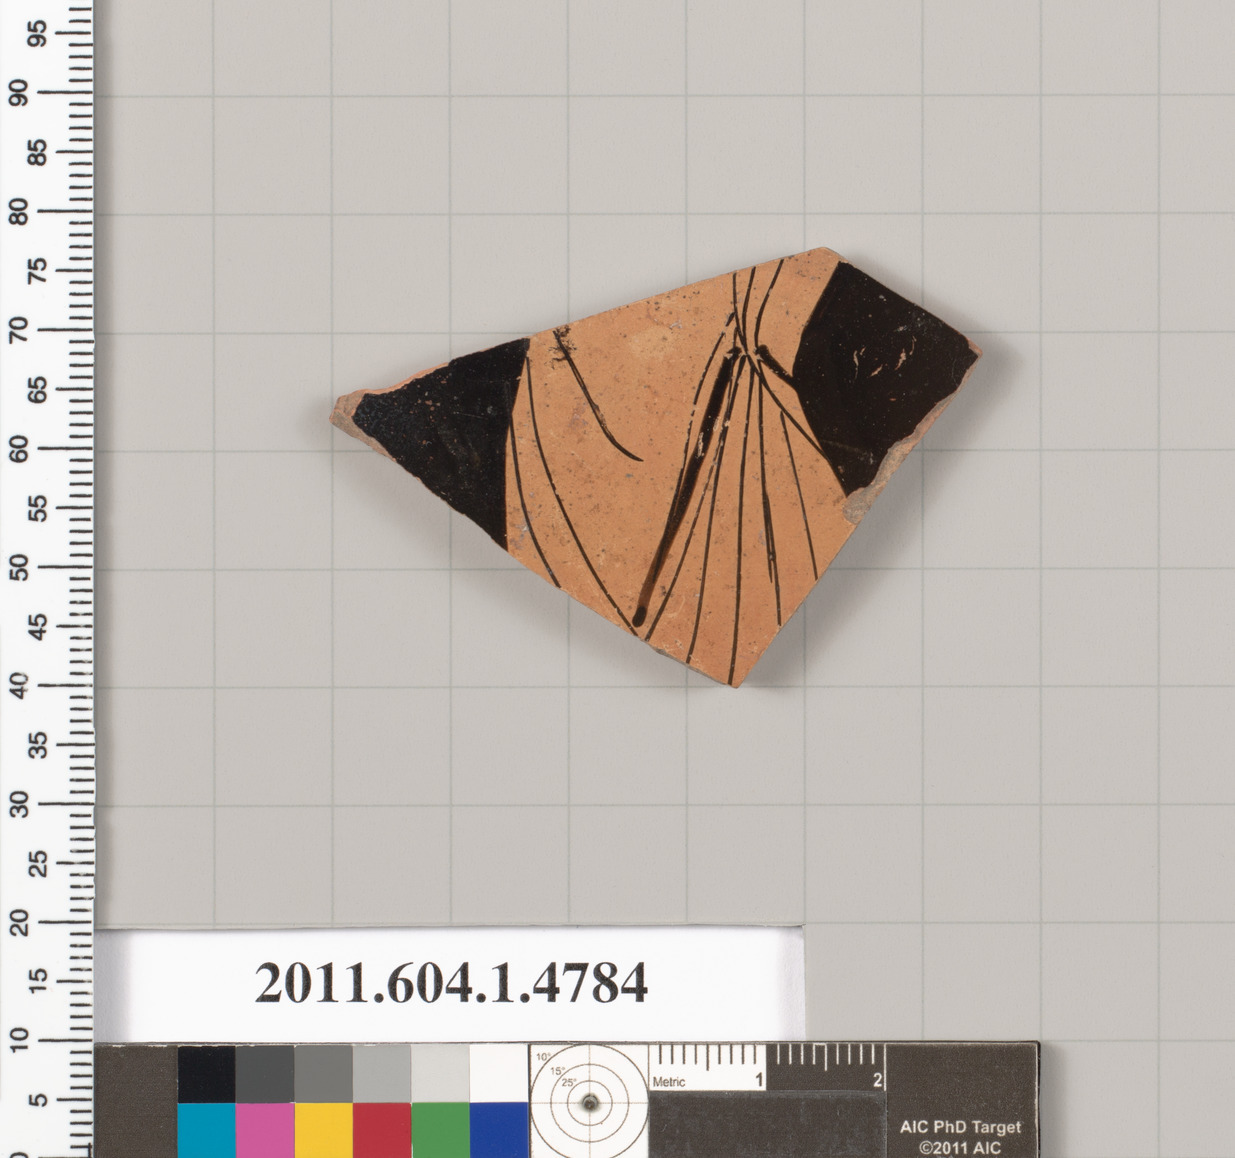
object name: kylix fragment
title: Terracotta fragment of a kylix (drinking cup)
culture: greek, attic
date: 475-451 BCE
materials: terracotta